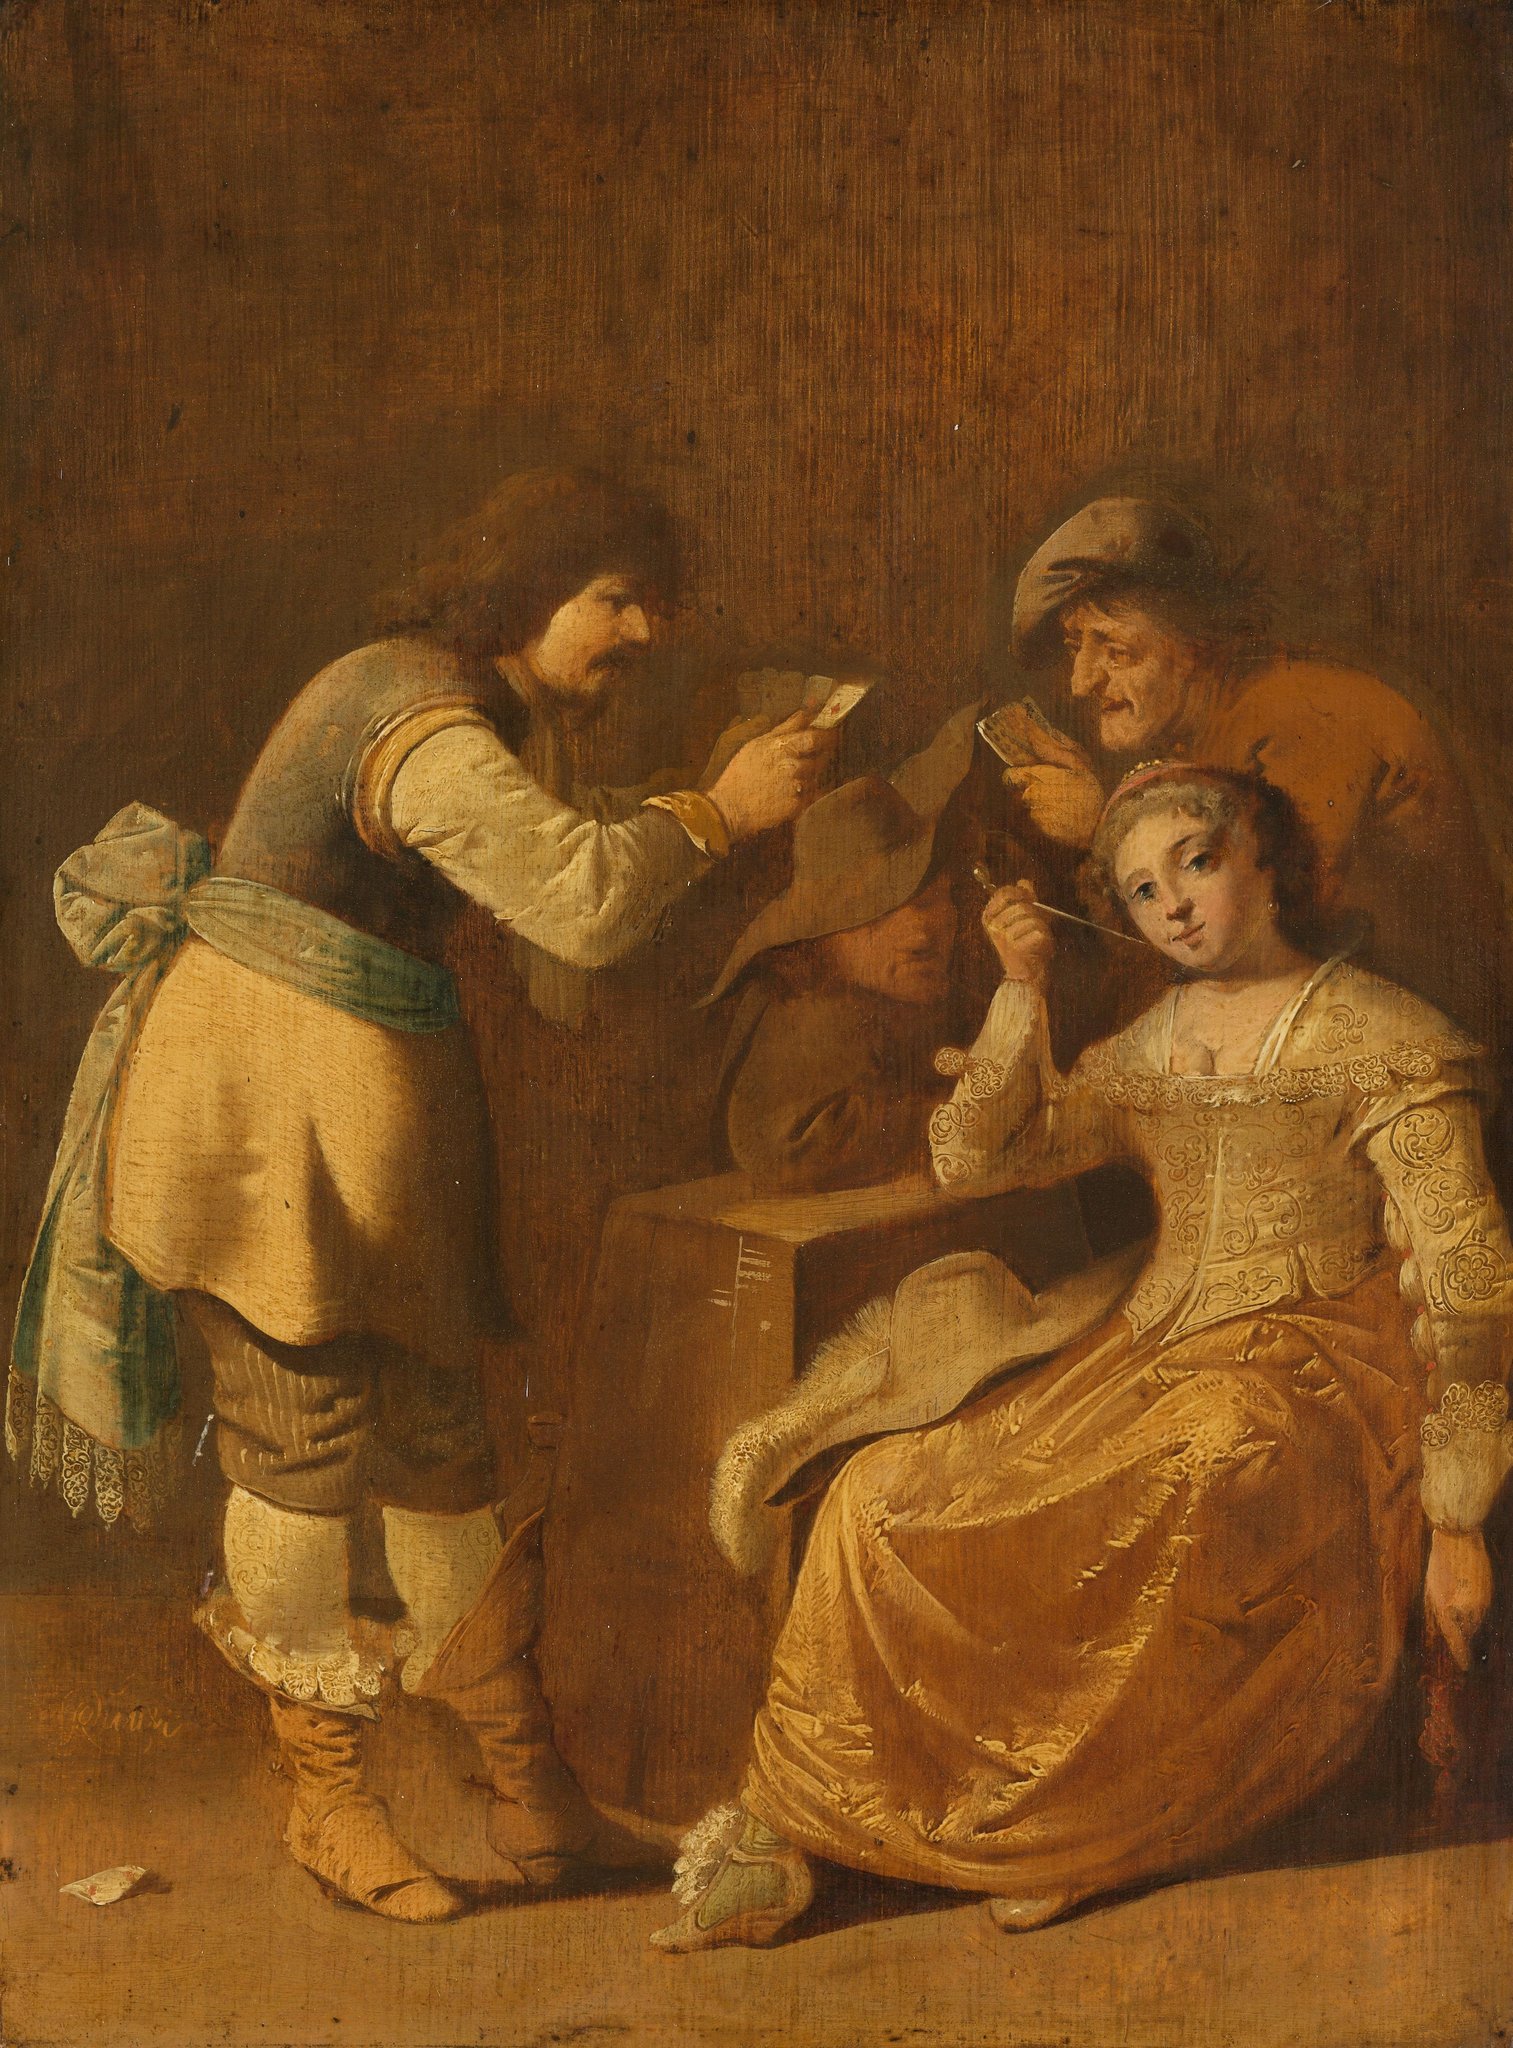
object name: painting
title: Card Players with Woman Smoking a Pipe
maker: pieter jansz quast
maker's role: draughtsman, painter, print maker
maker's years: 1605-1647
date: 1635-1640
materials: oil, panel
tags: inn, coffee-house, public house, etc., pipe ~ tobacco, card games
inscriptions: signature, lower left (P and Q ligated): ‘PQuast’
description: Twee staande kaartspelers en een zittende pijprokende vrouw.